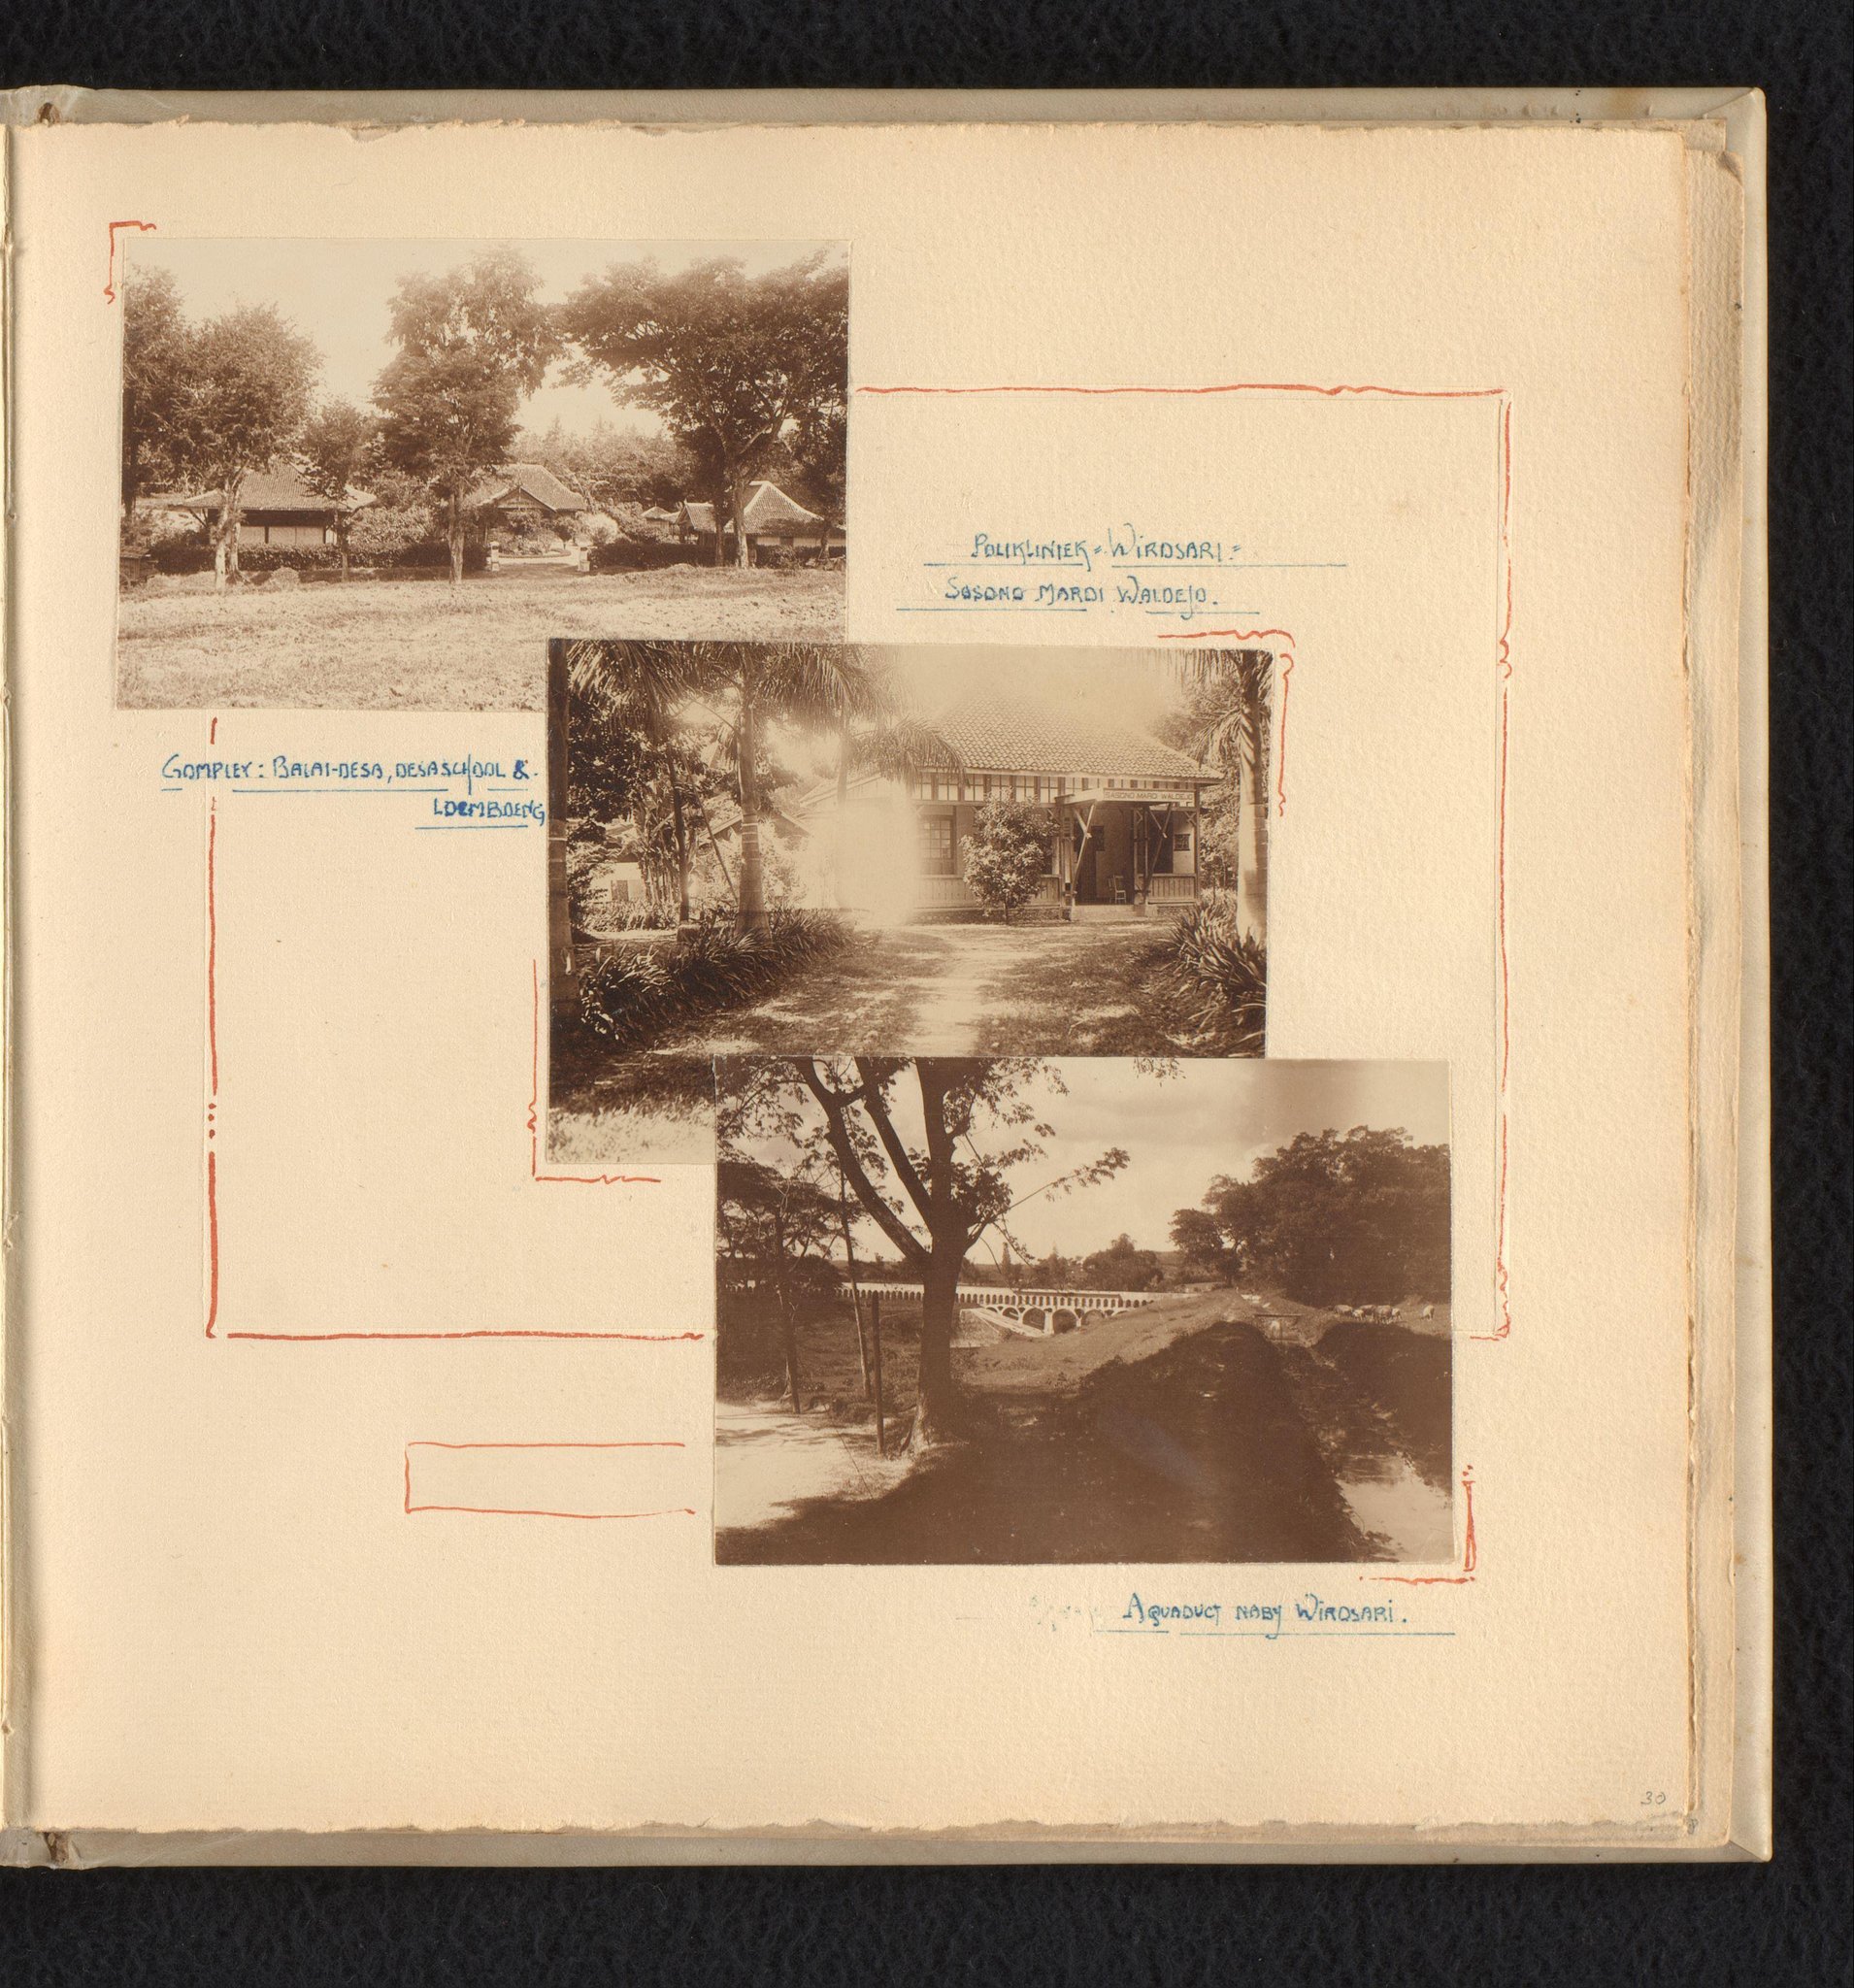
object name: photograph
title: Verschillende bouwwerken in Grobogan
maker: Anonymous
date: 1910-1928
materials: paper, photographic support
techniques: drawing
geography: grobogan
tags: aqueduct (~ water supply), hospital, elementary school; class, form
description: Albumblad met drie foto's van een polikliniek, dorpsschool en een aquaduct in Grobogan. Het blad is versierd met randwerk om de foto's. Onderdeel van het fotoalbum aangeboden aan J. Habbema door het Binnenlandsch Bestuur Corps van het Regentschap Grobogan, bij het beëindigen van zijn bestuur over het Regentschap, waarschijnlijk in 1928.